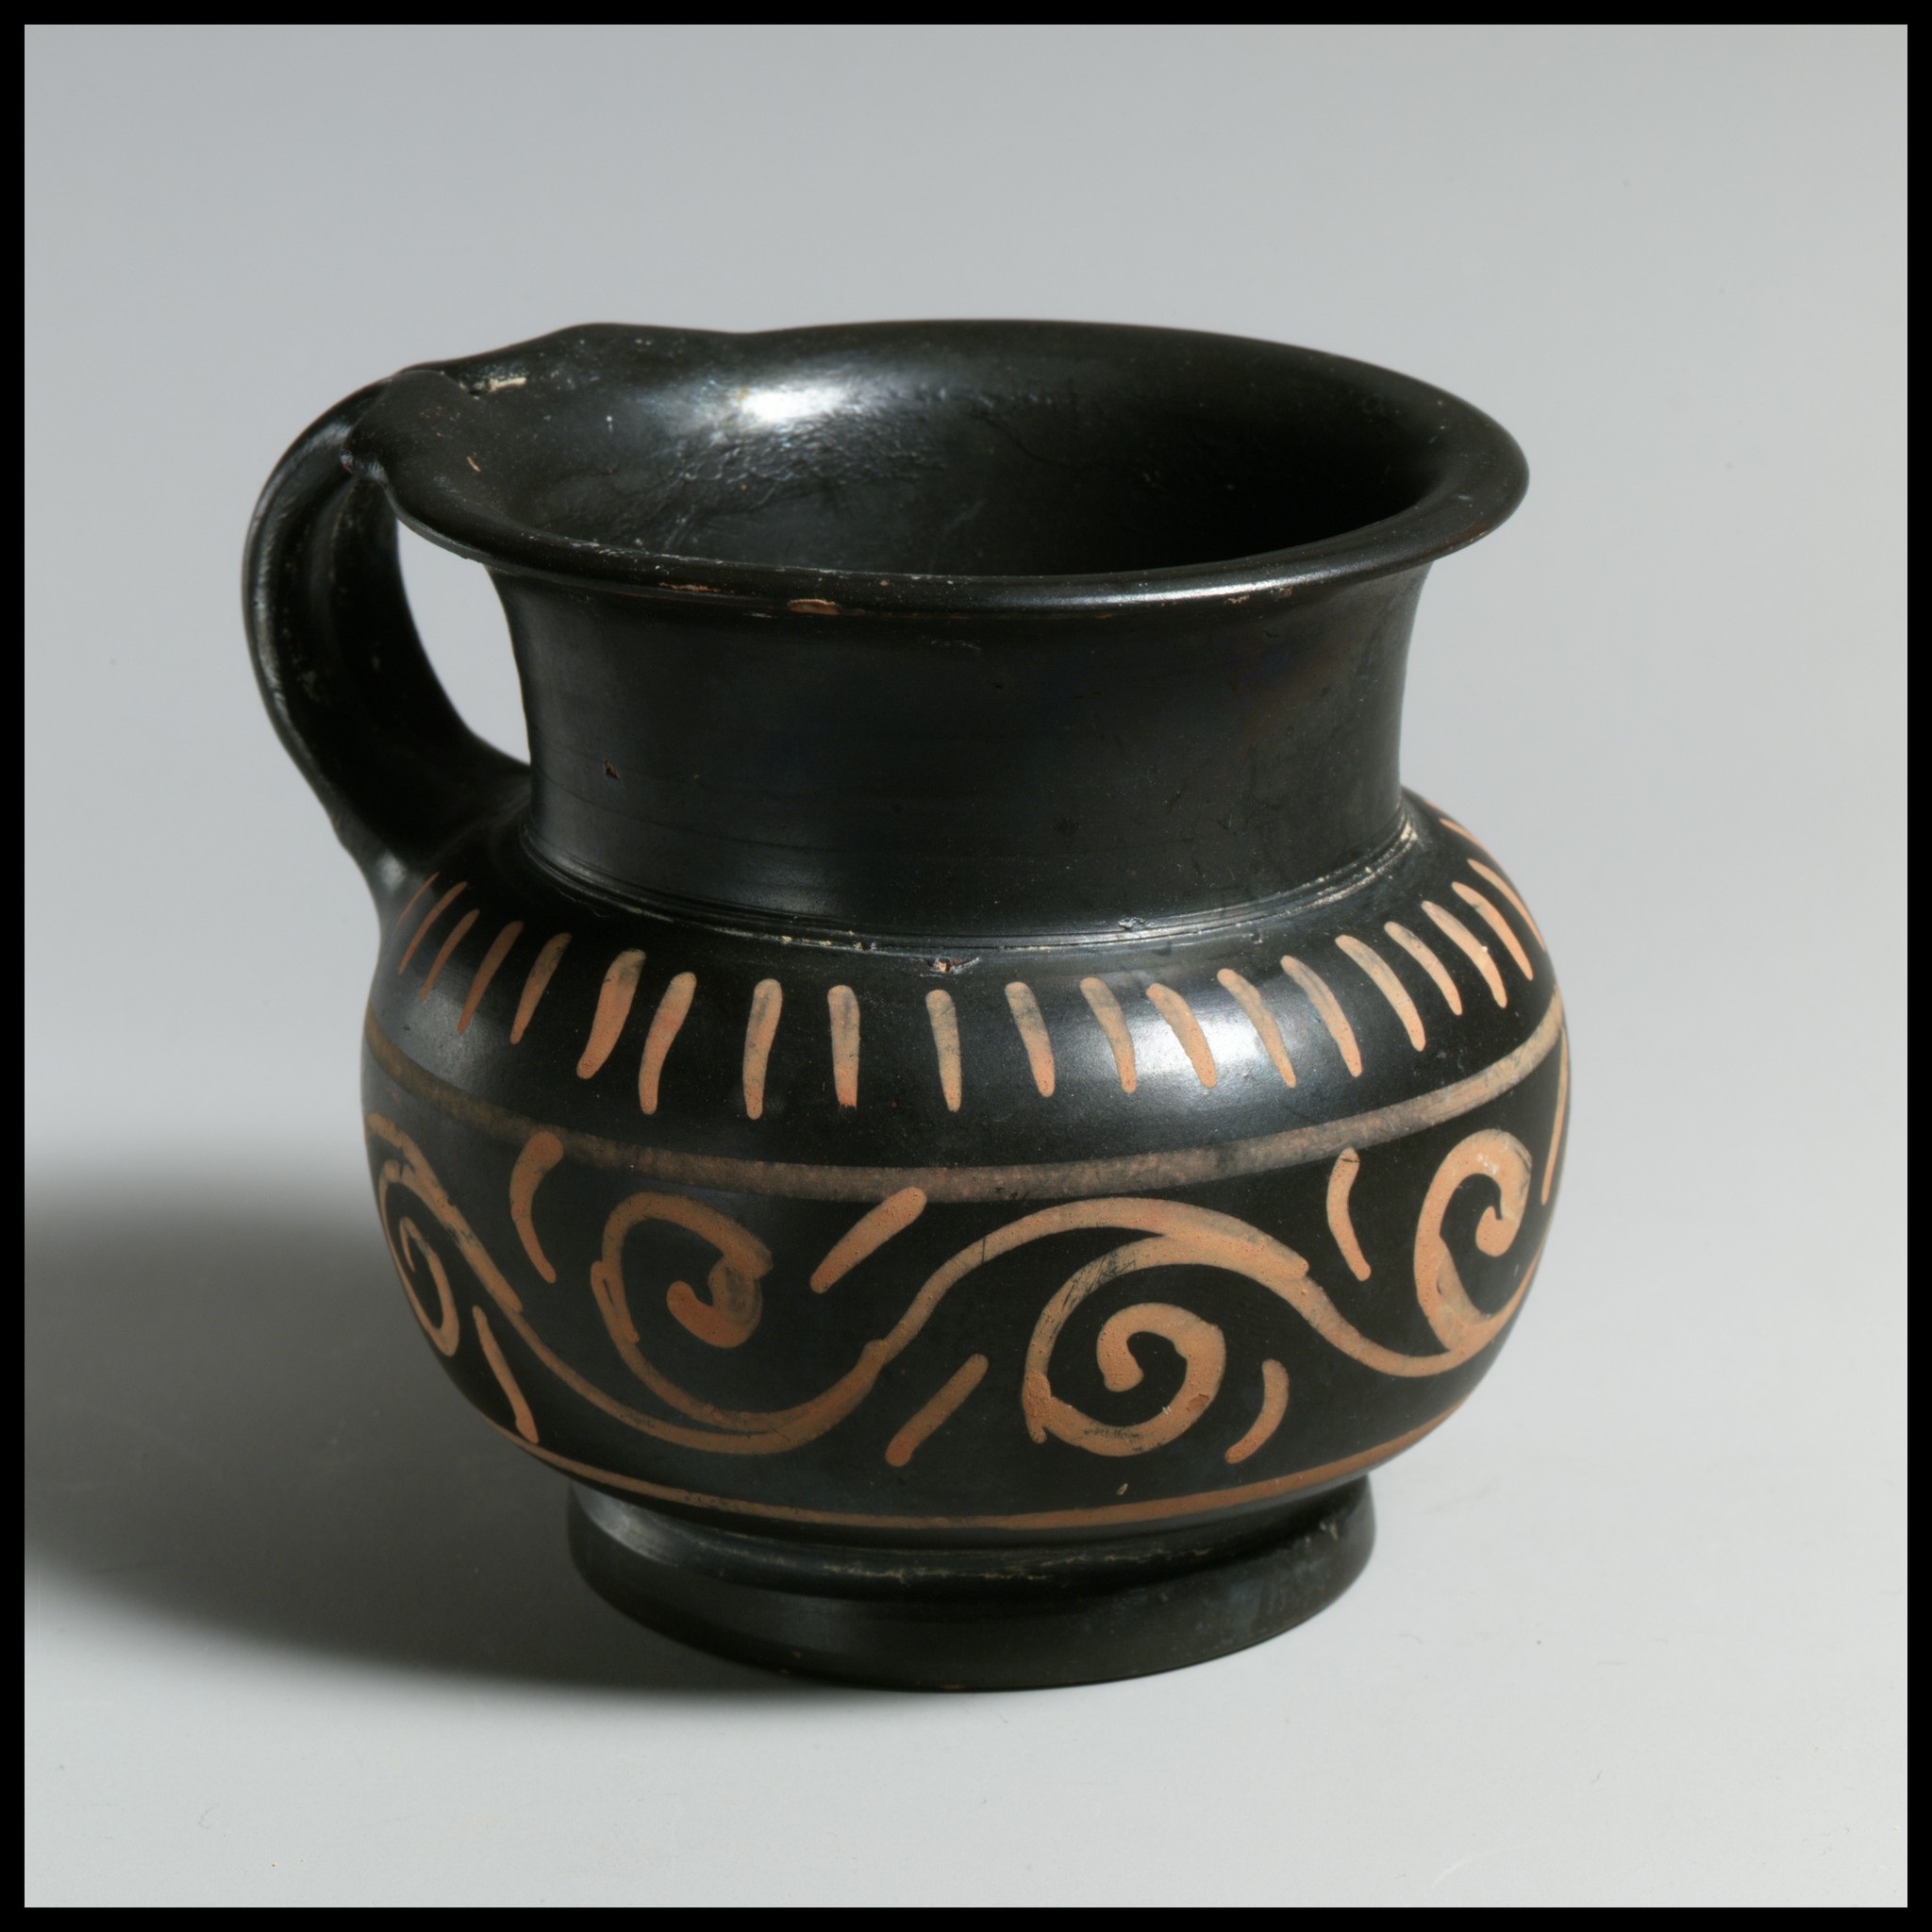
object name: mug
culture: greek, south italian, apulian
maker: xenon group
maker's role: artist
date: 400-301 BCE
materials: terracotta